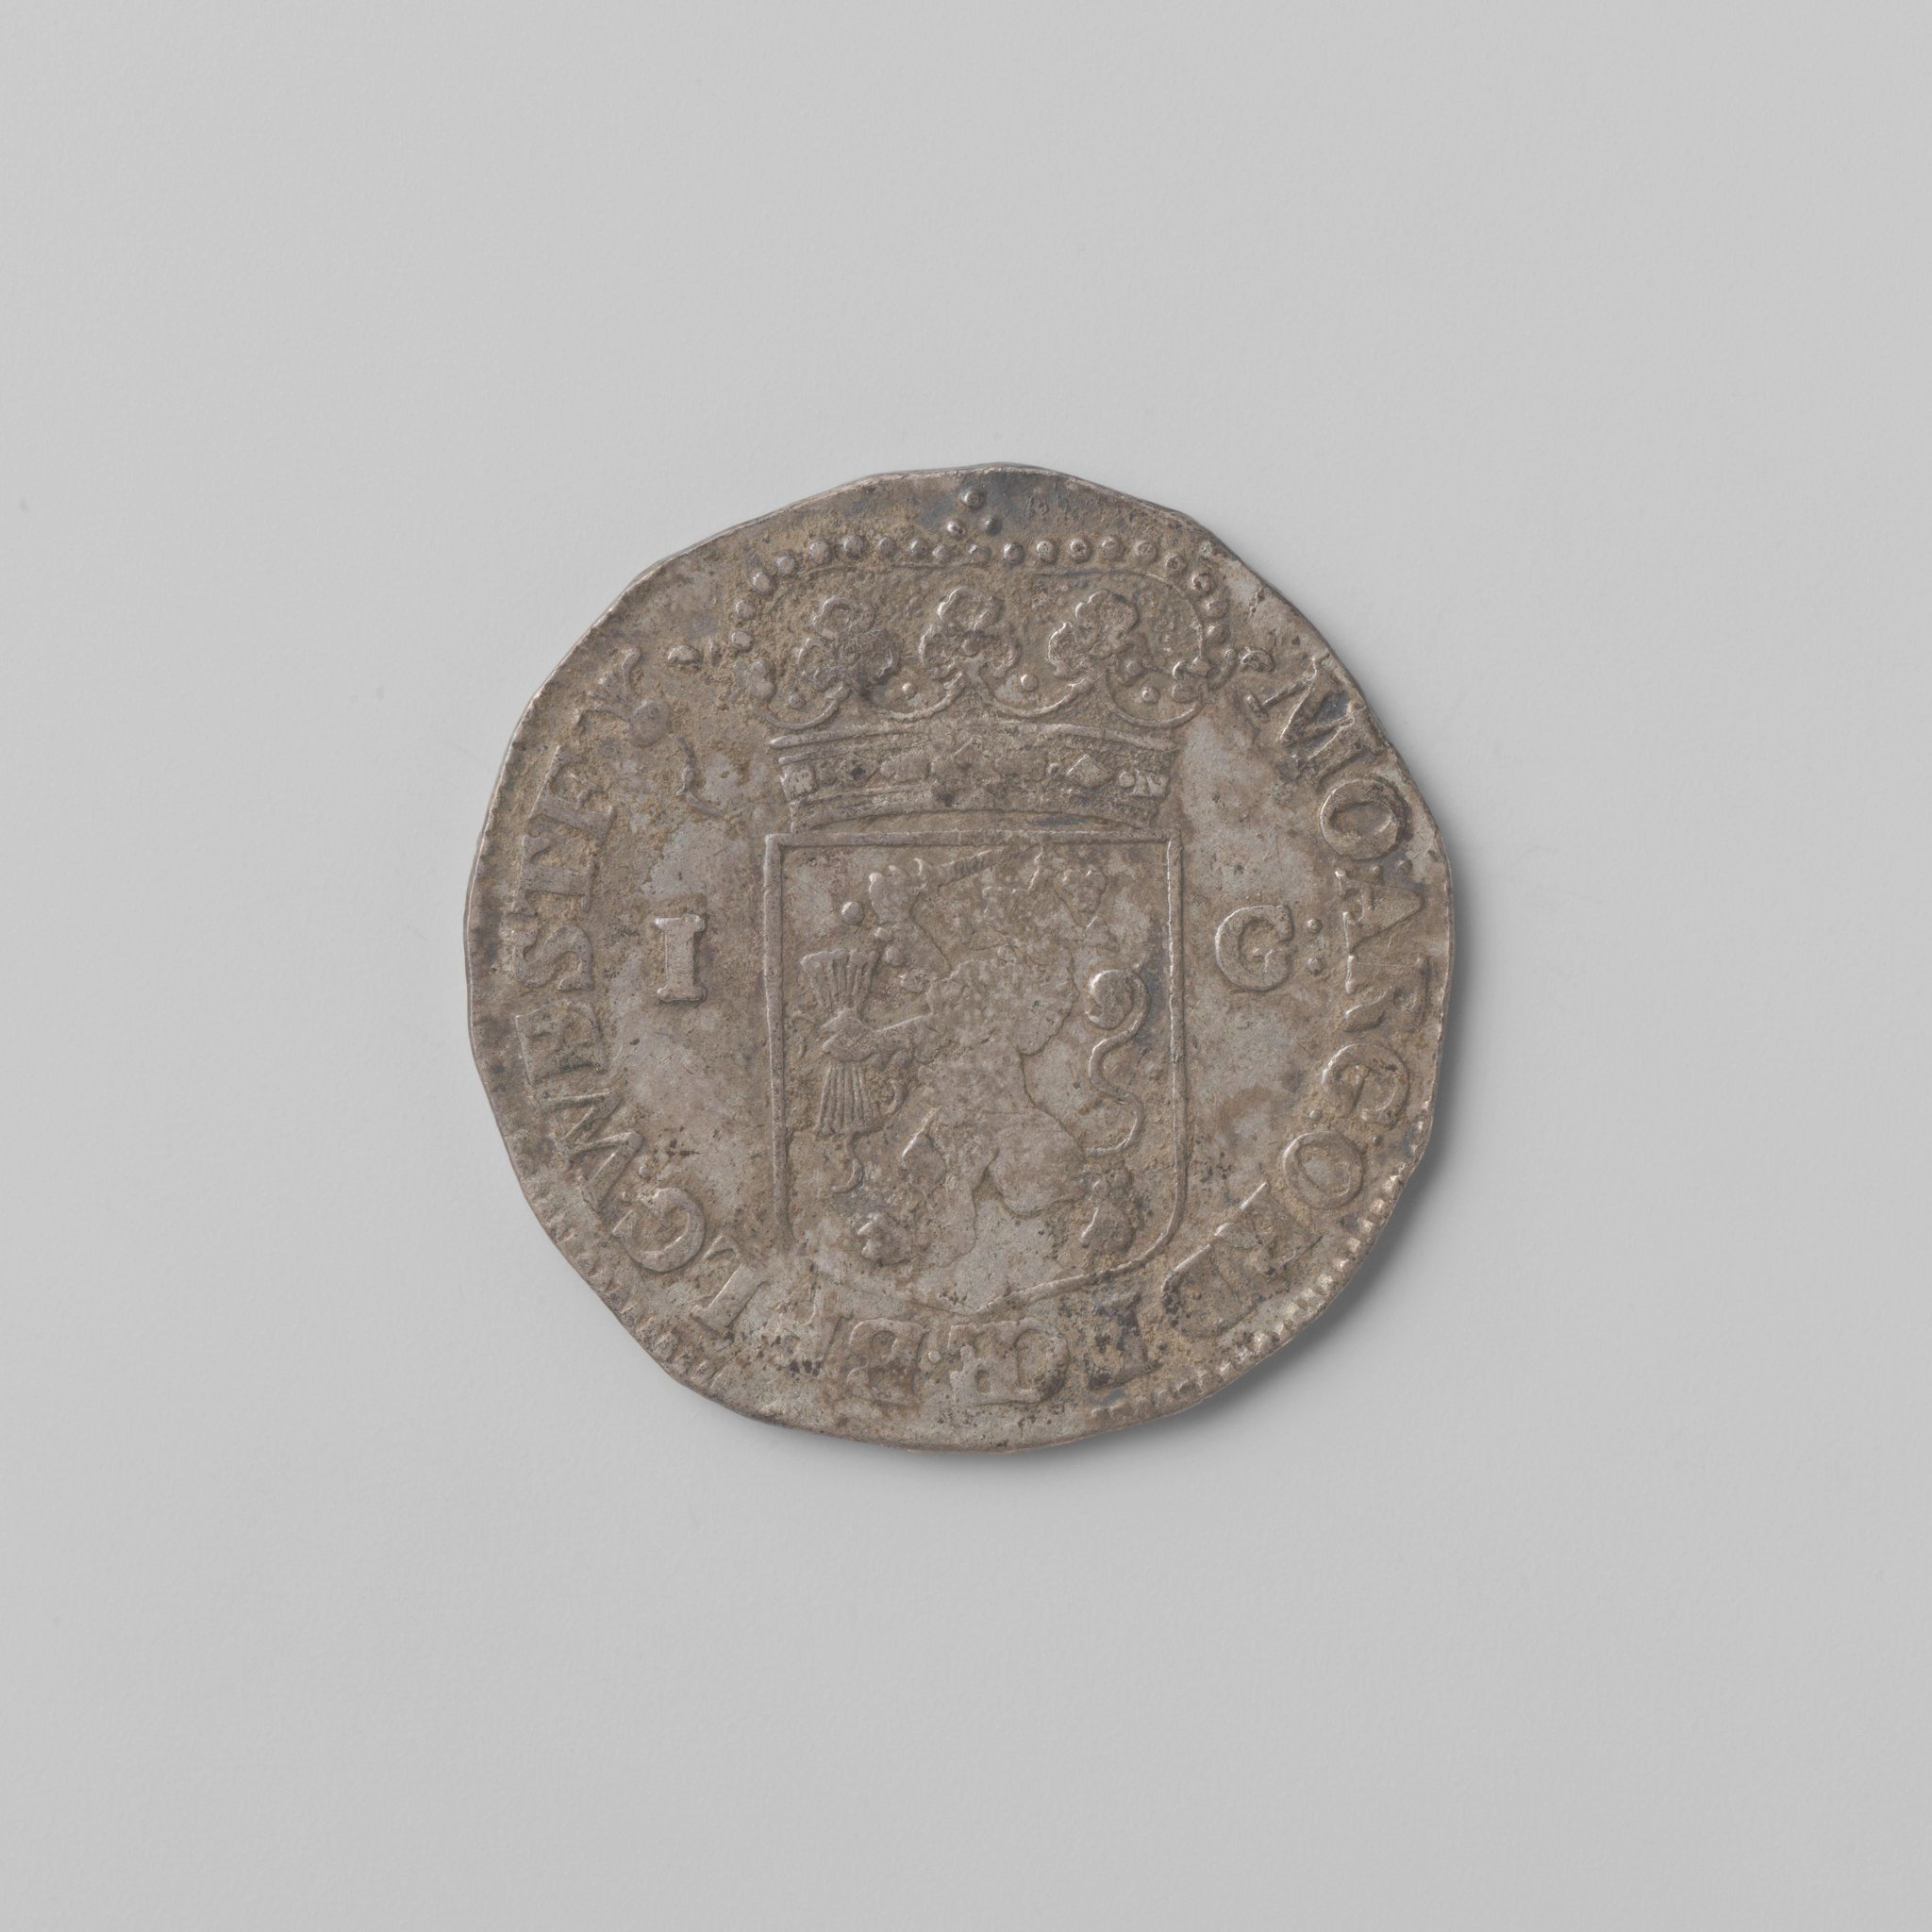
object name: coin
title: Westfriese gulden, 1735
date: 1735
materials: silver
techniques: striking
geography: west frisia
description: Zilveren munt. Voorzijde: tussen waarde-aanduiding gekroond generaliteirtswapenschild. Keerzijde: Nederlandse maagd met vrijheidshoed en speer, leunend op een bijbel op een altaar. In afsnede jaartal. Gladde rand.